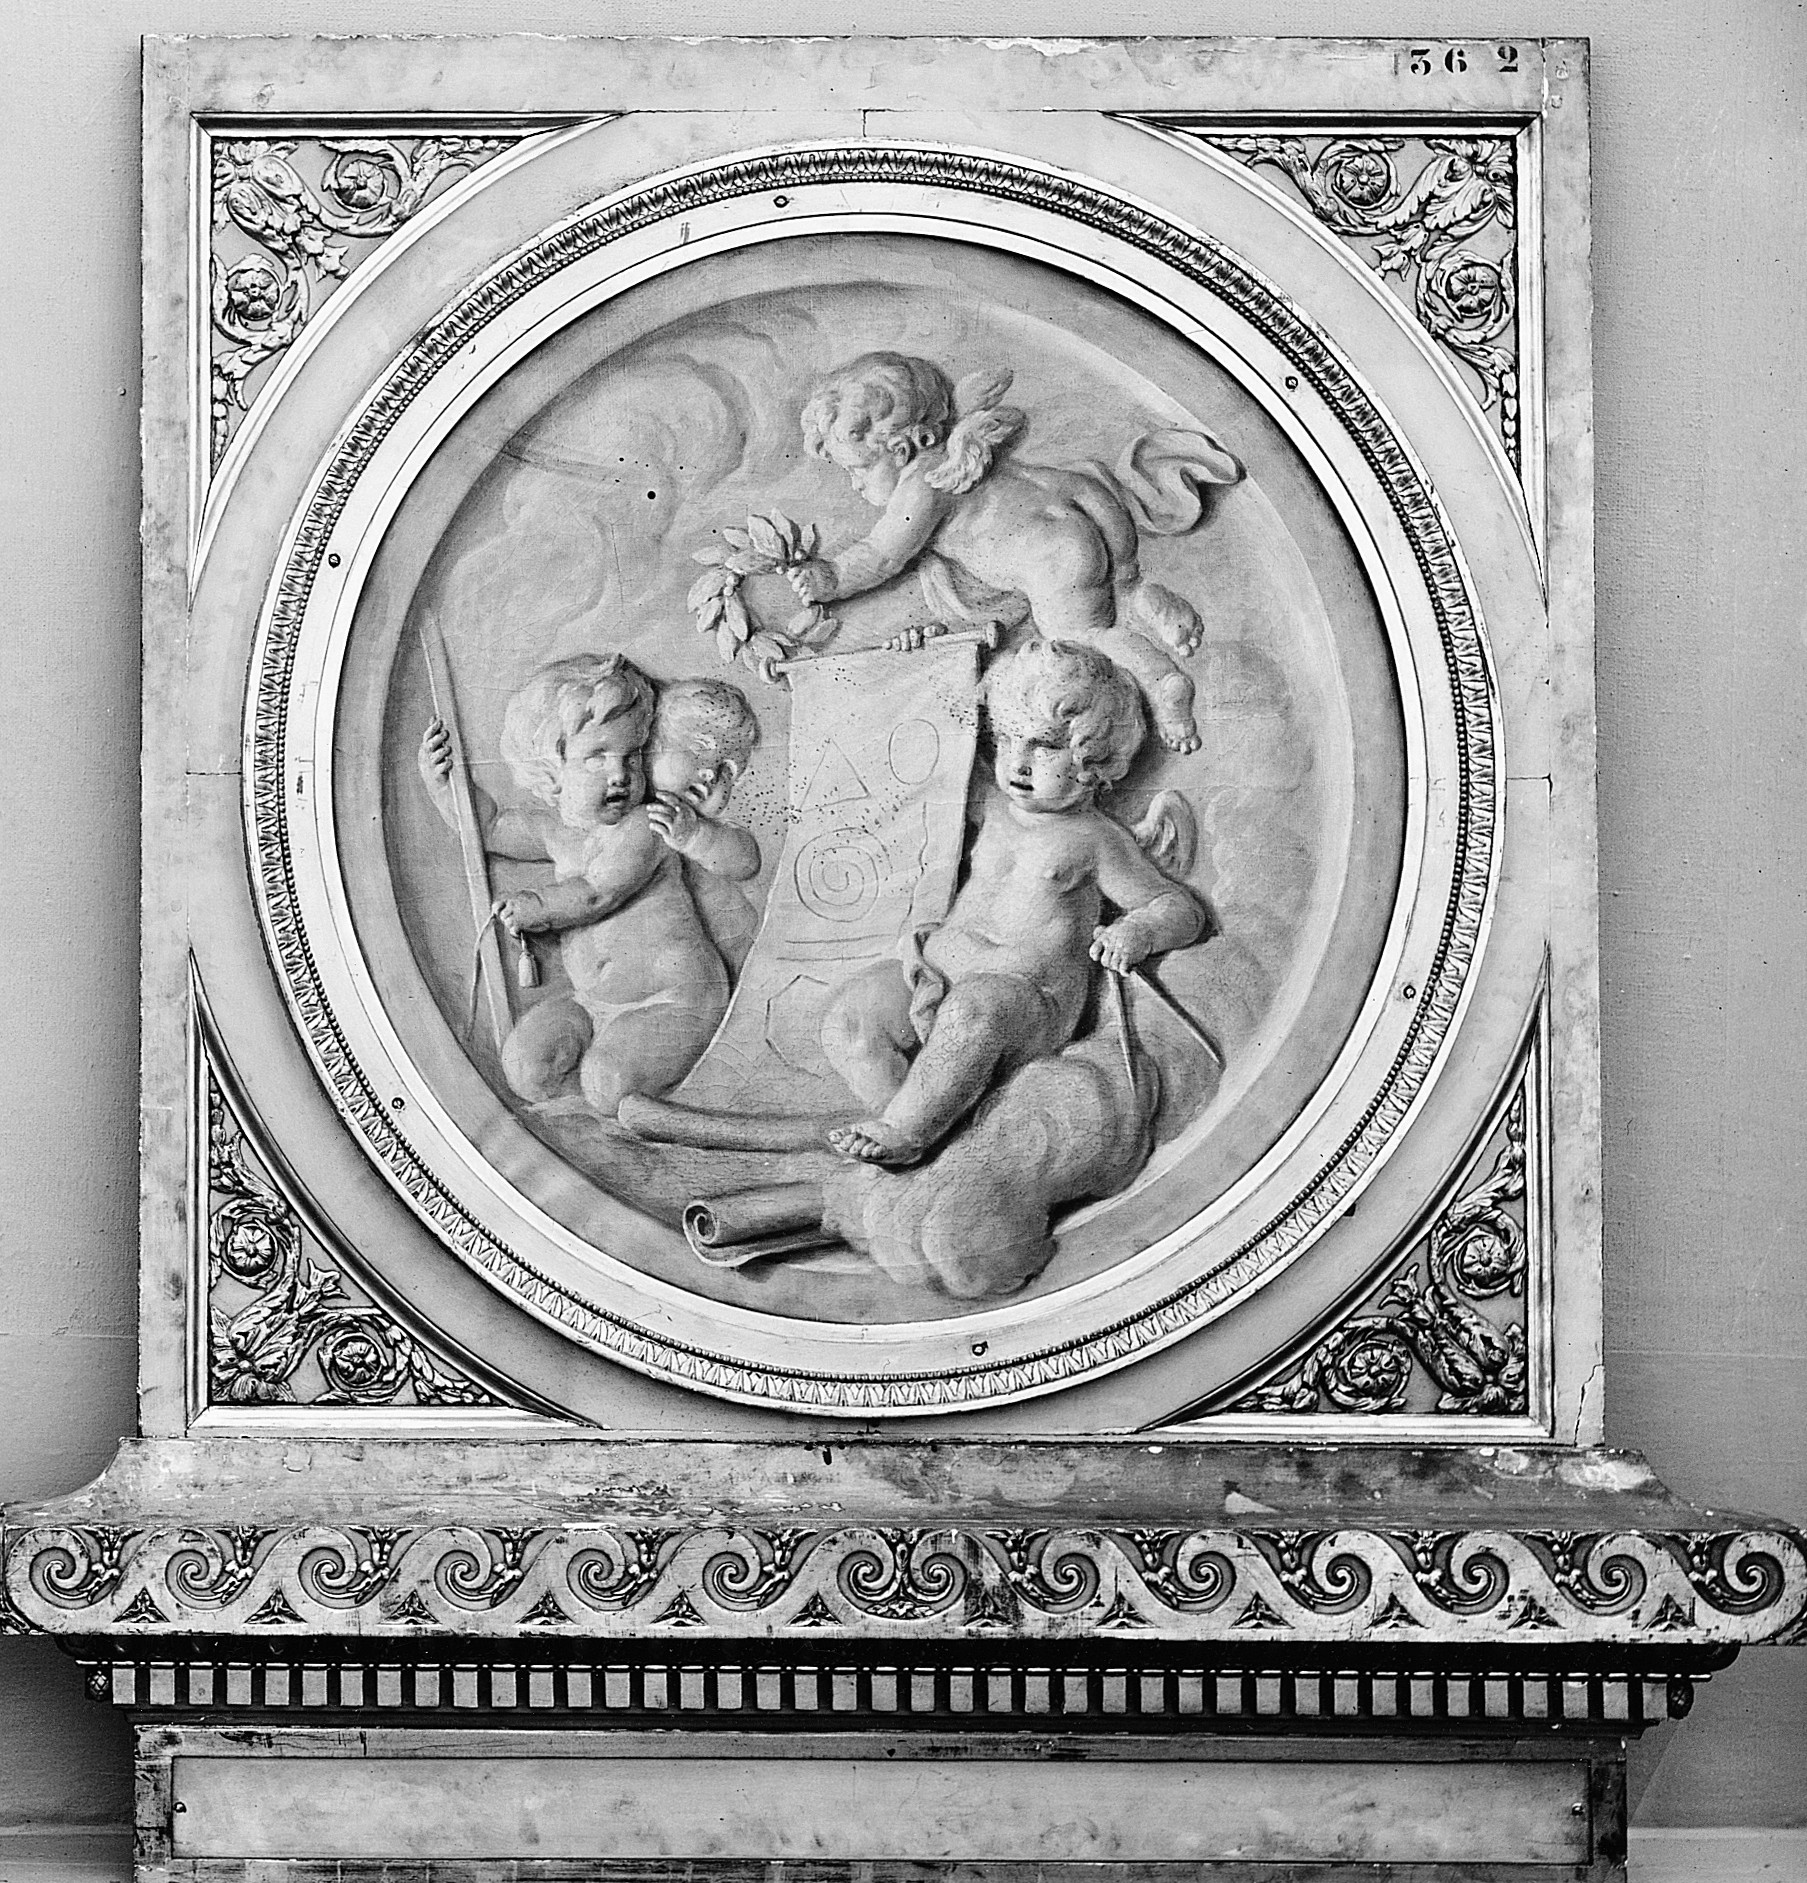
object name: overdoor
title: Mathematics (one of a pair)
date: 1770-1790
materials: canvas, oil, wood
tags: children,mathematics